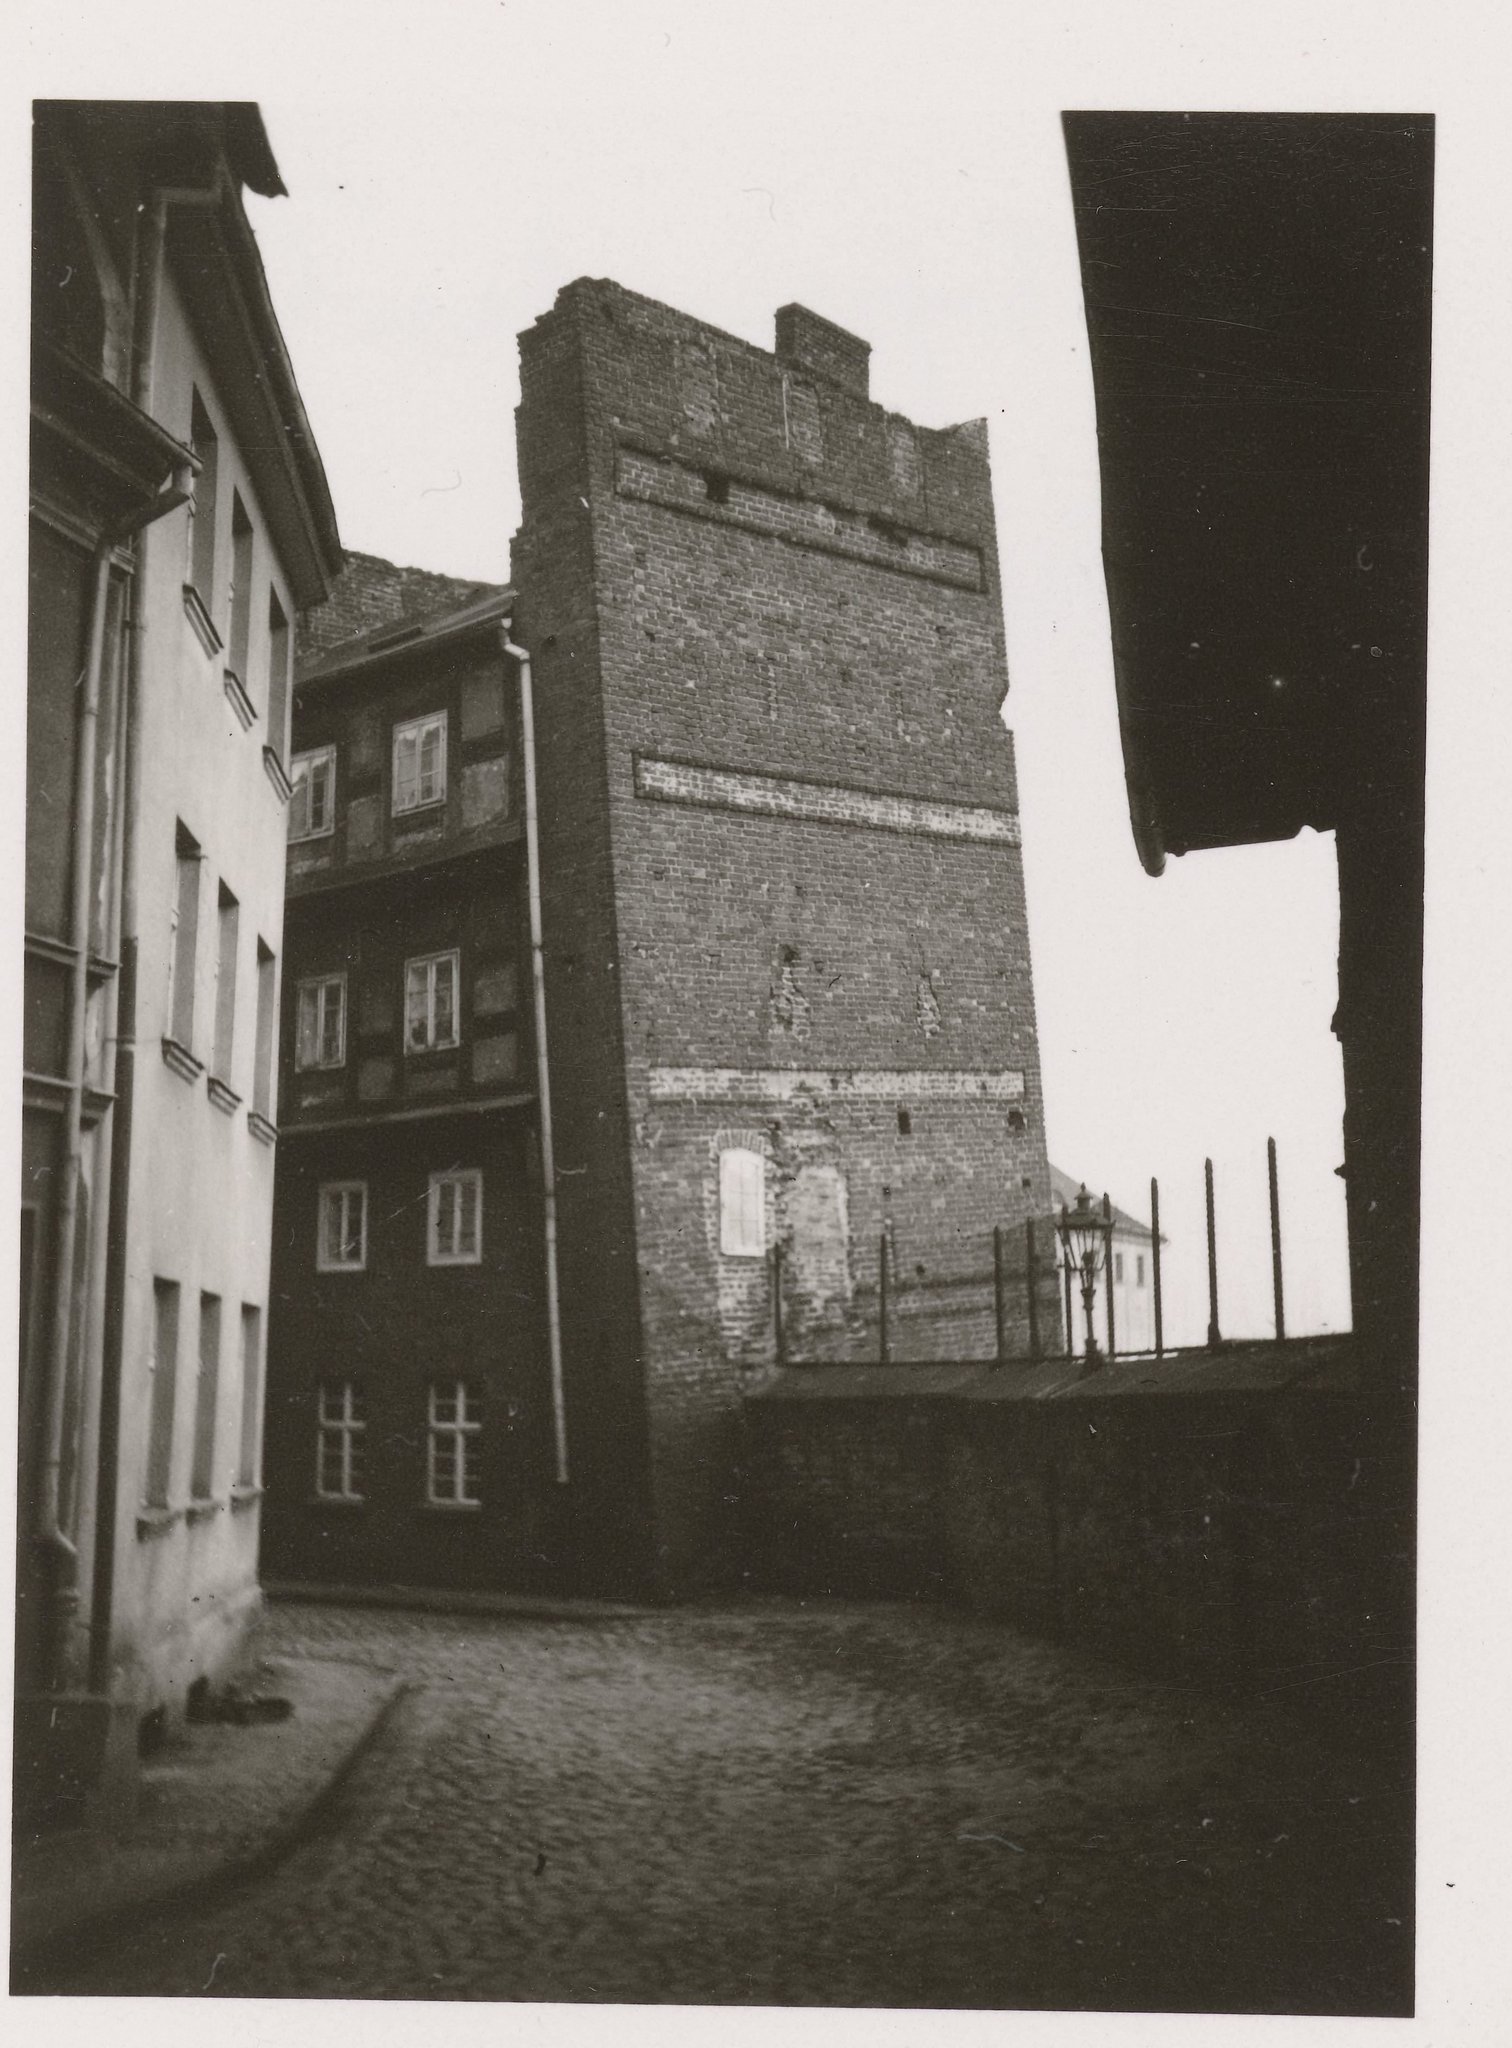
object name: photograph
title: Een straat met een afgebroken huis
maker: Anonymous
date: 1940-1945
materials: photographic support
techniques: gelatin silver print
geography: germany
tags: netherlands, germany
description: Een straat met een afgebroken huis. Achterop foto tekst in het Duits. Foto behorend bij album 'Kriegserinnerungen'.